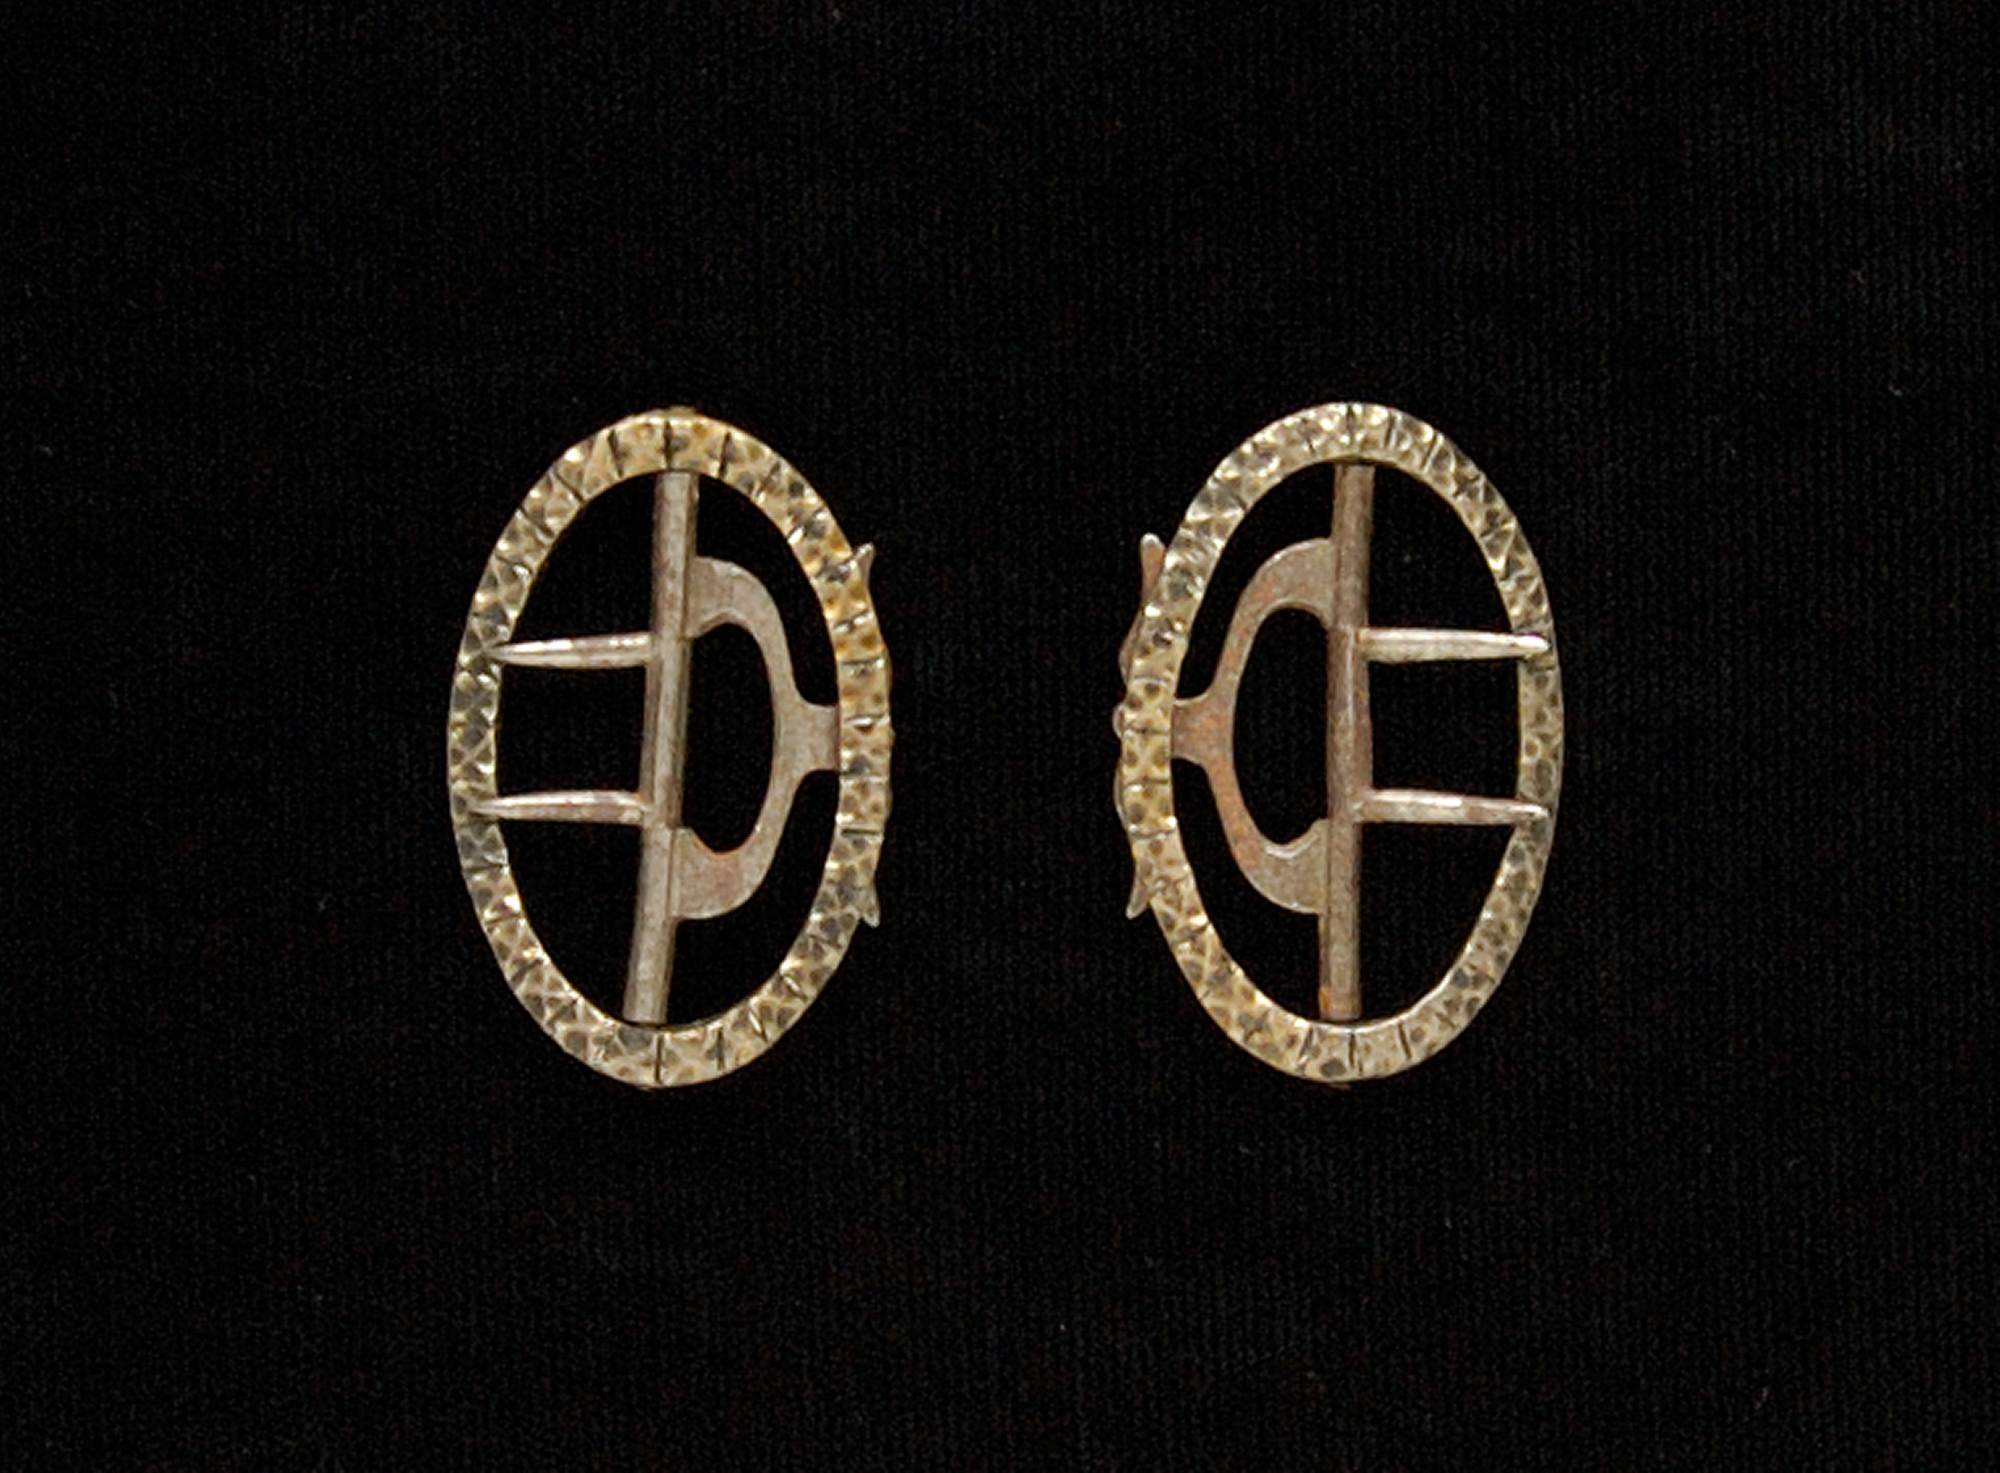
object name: shoe buckle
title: Shoe buckles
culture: european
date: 1770-1790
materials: metal